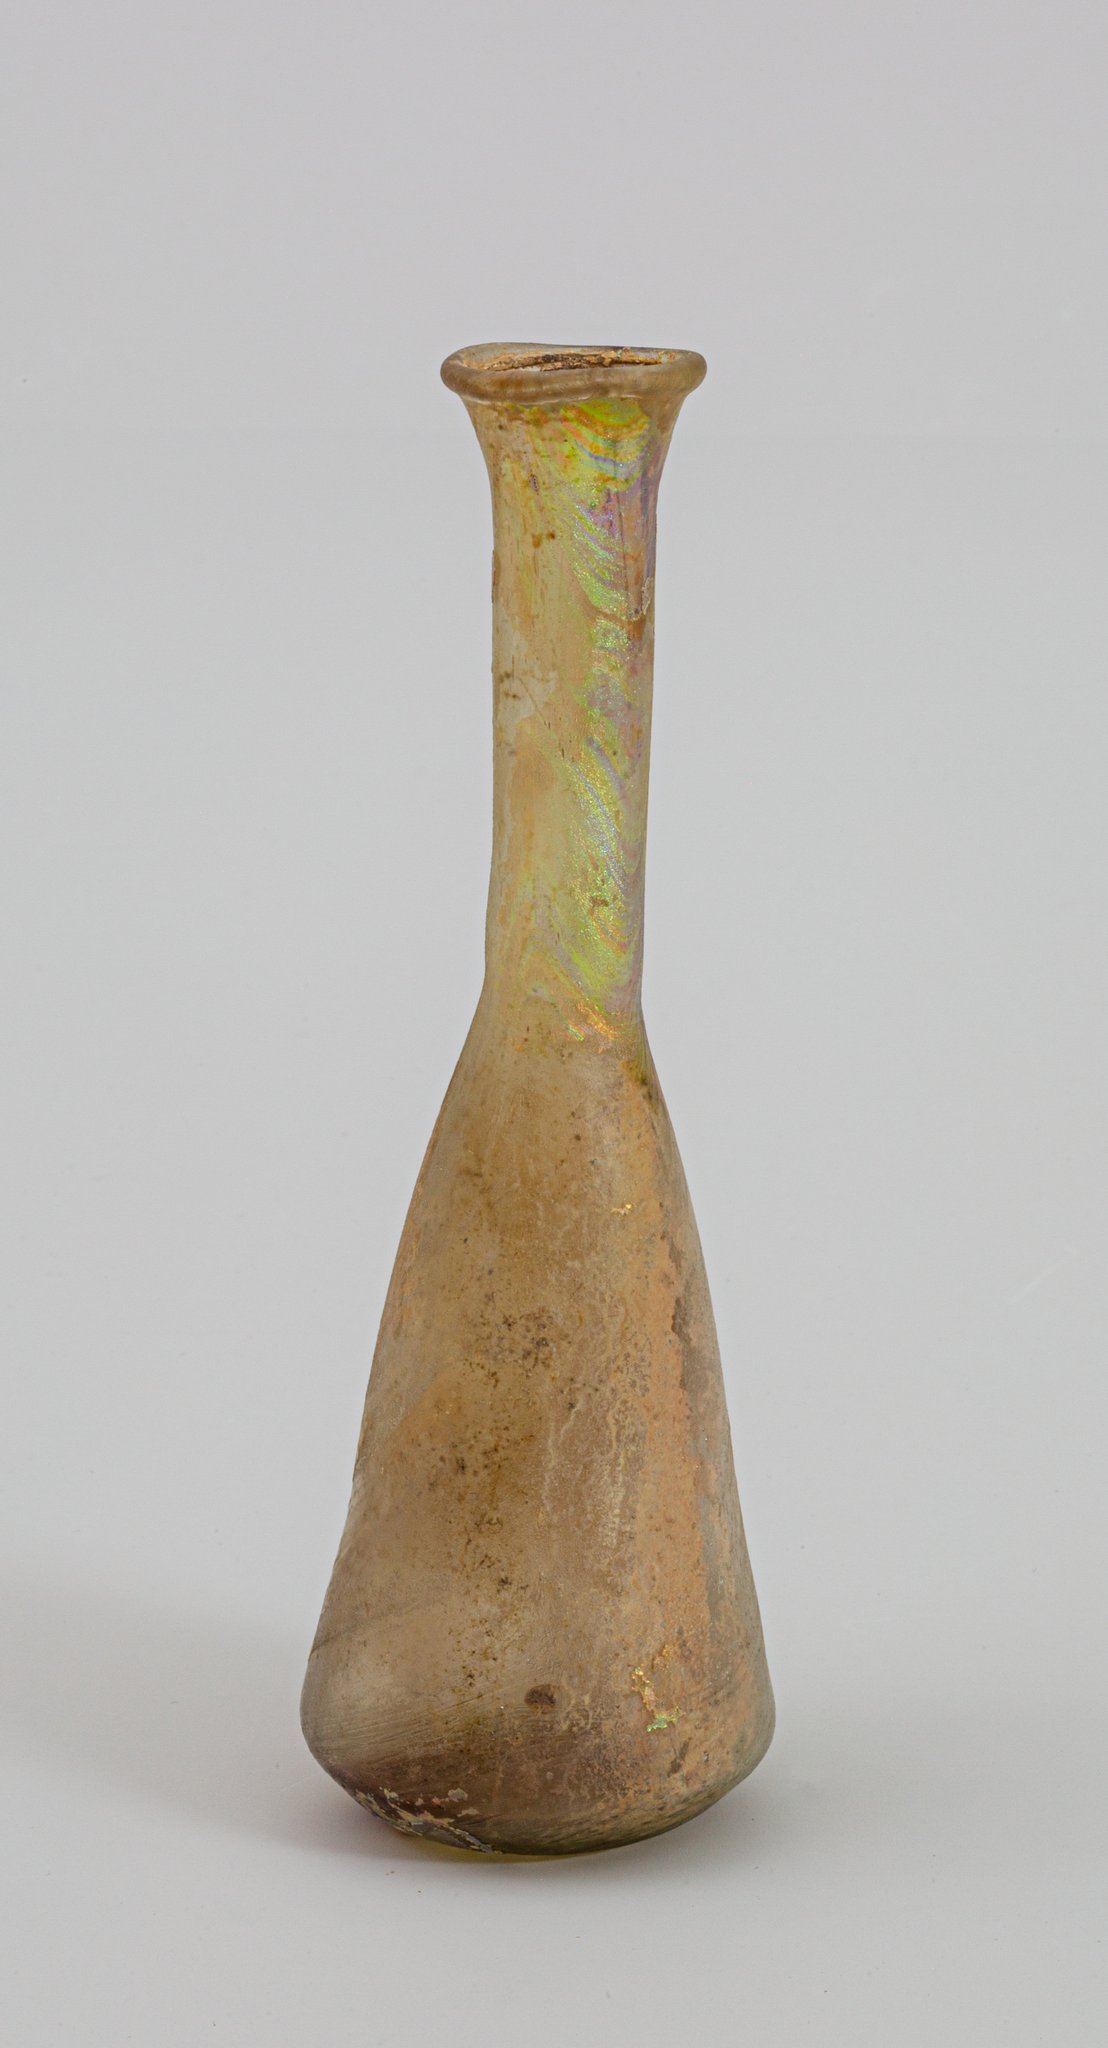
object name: perfume bottle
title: Glass perfume bottle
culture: roman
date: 101-300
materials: glass